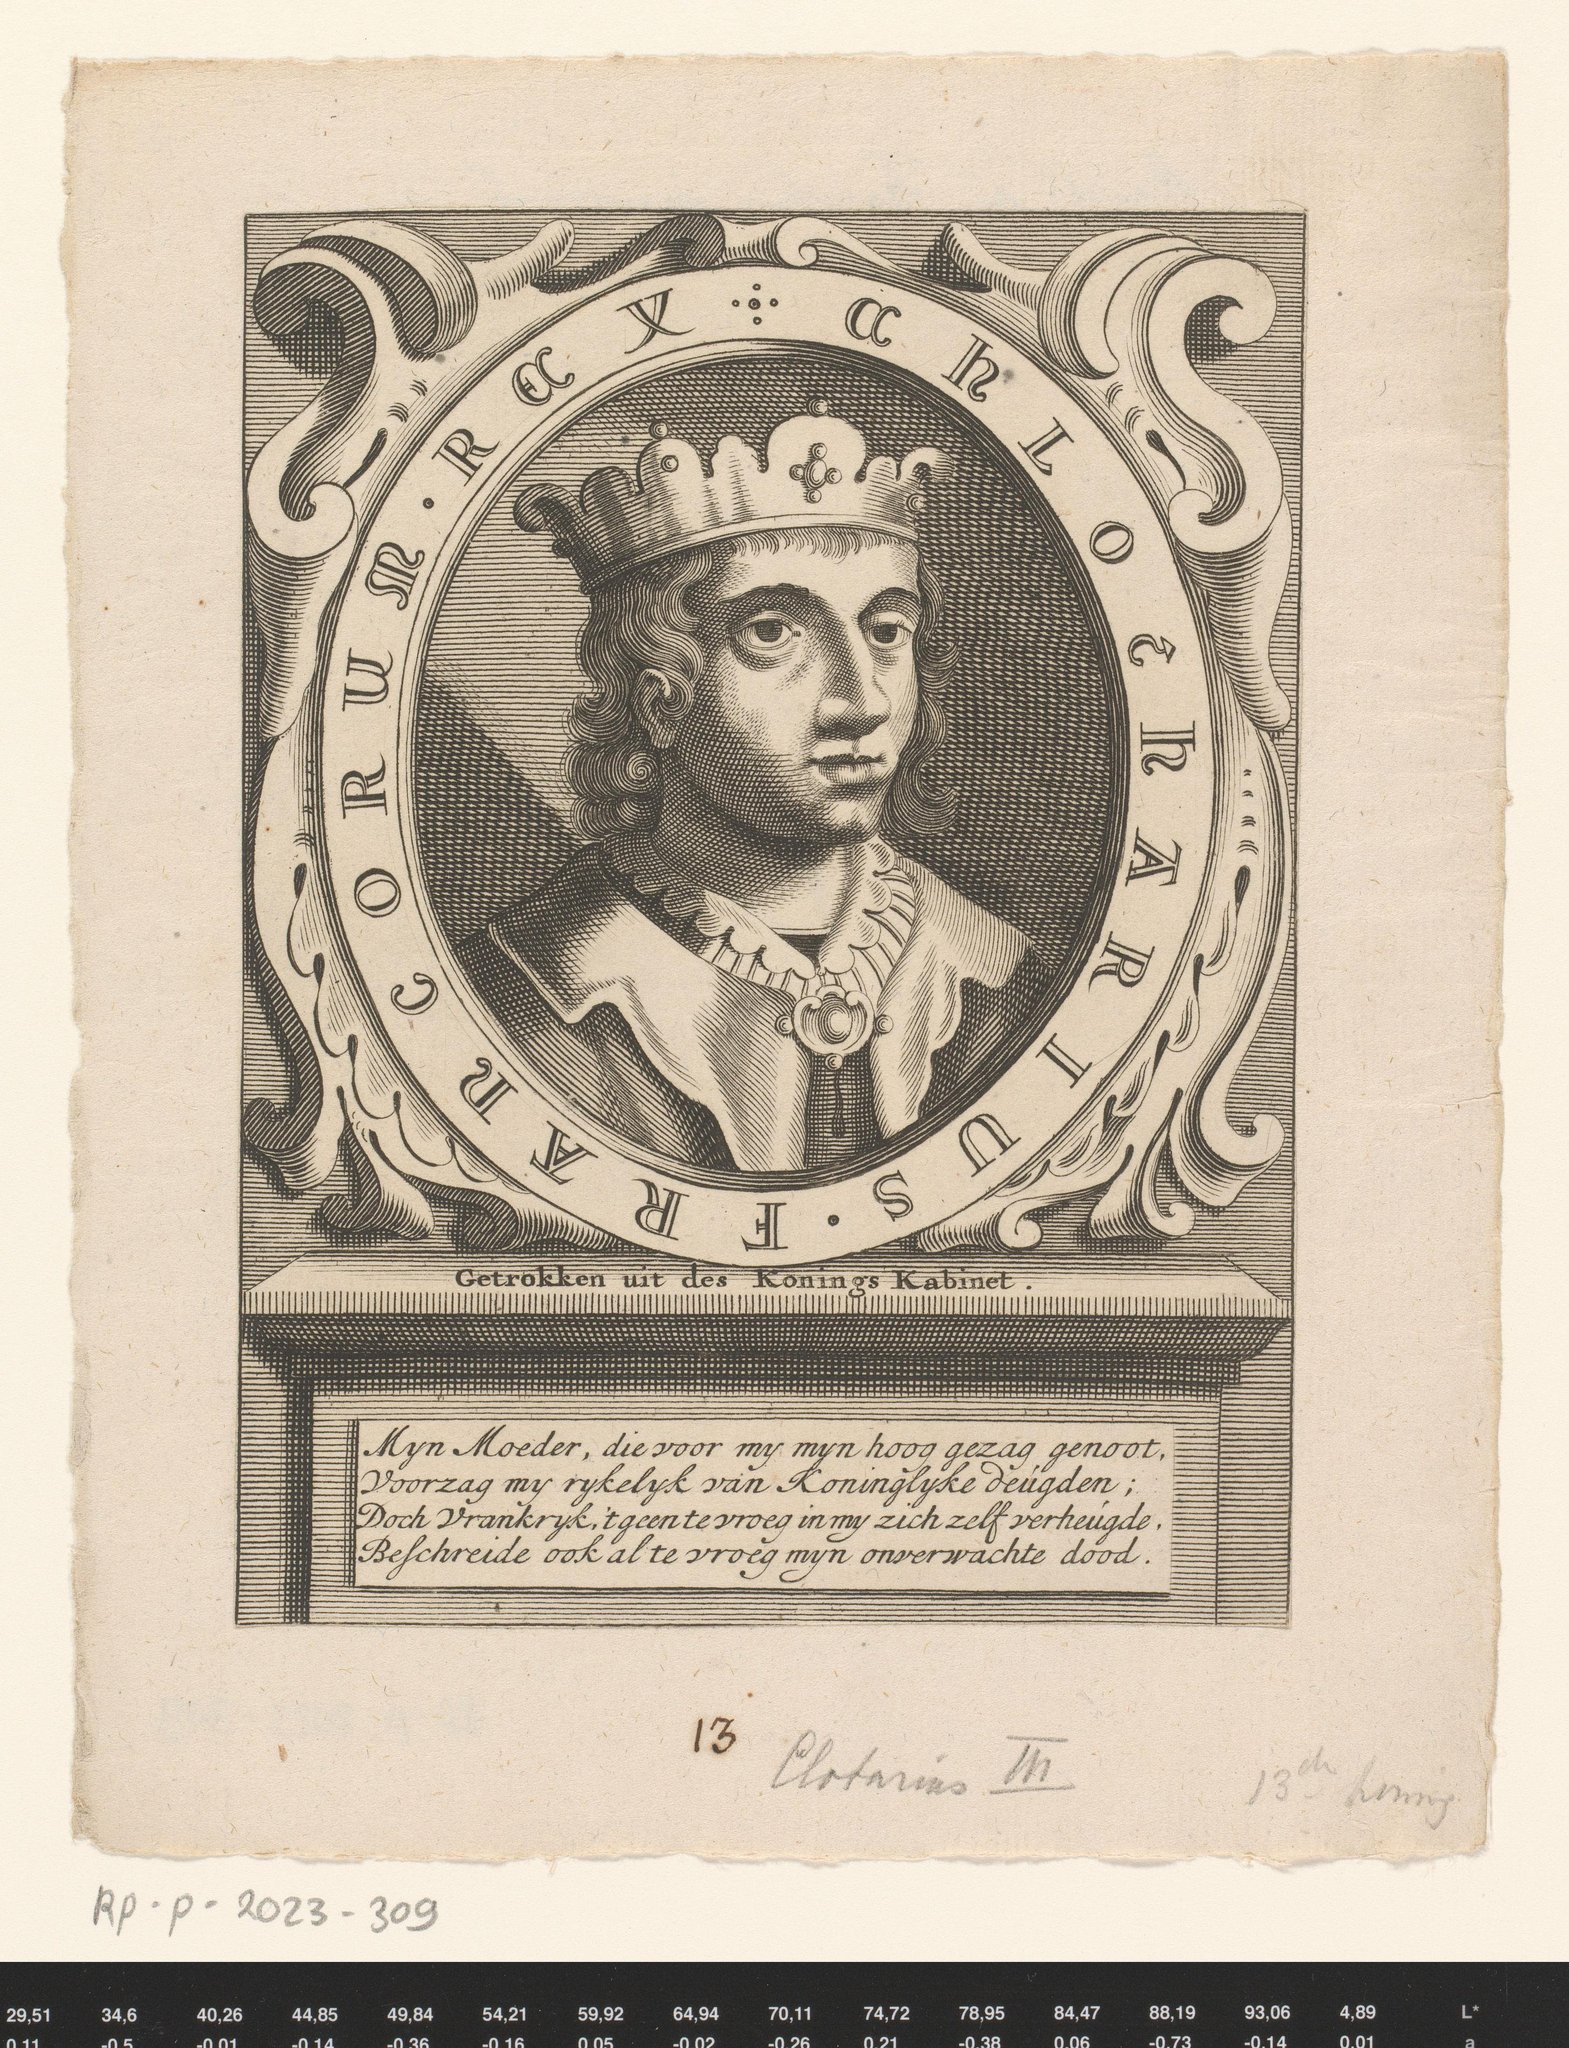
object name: print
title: Portret van Chlotharius III, koning van Neustrië en Bourgondië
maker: Anonymous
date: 1685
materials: paper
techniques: engraving, etching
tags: historical persons, king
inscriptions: number: ‘13’, collector's mark: Lugt 2228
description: Prent waarschijnlijk uit: Mézeray, François Eudes de. Chronyk van Vrankryk. [Vertaald uit het Frans door] G. v. Broekhuizen. Amsterdam: Timotheus ten Hoorn en Jan Bouman, 1685, dl. 1, p. 124.